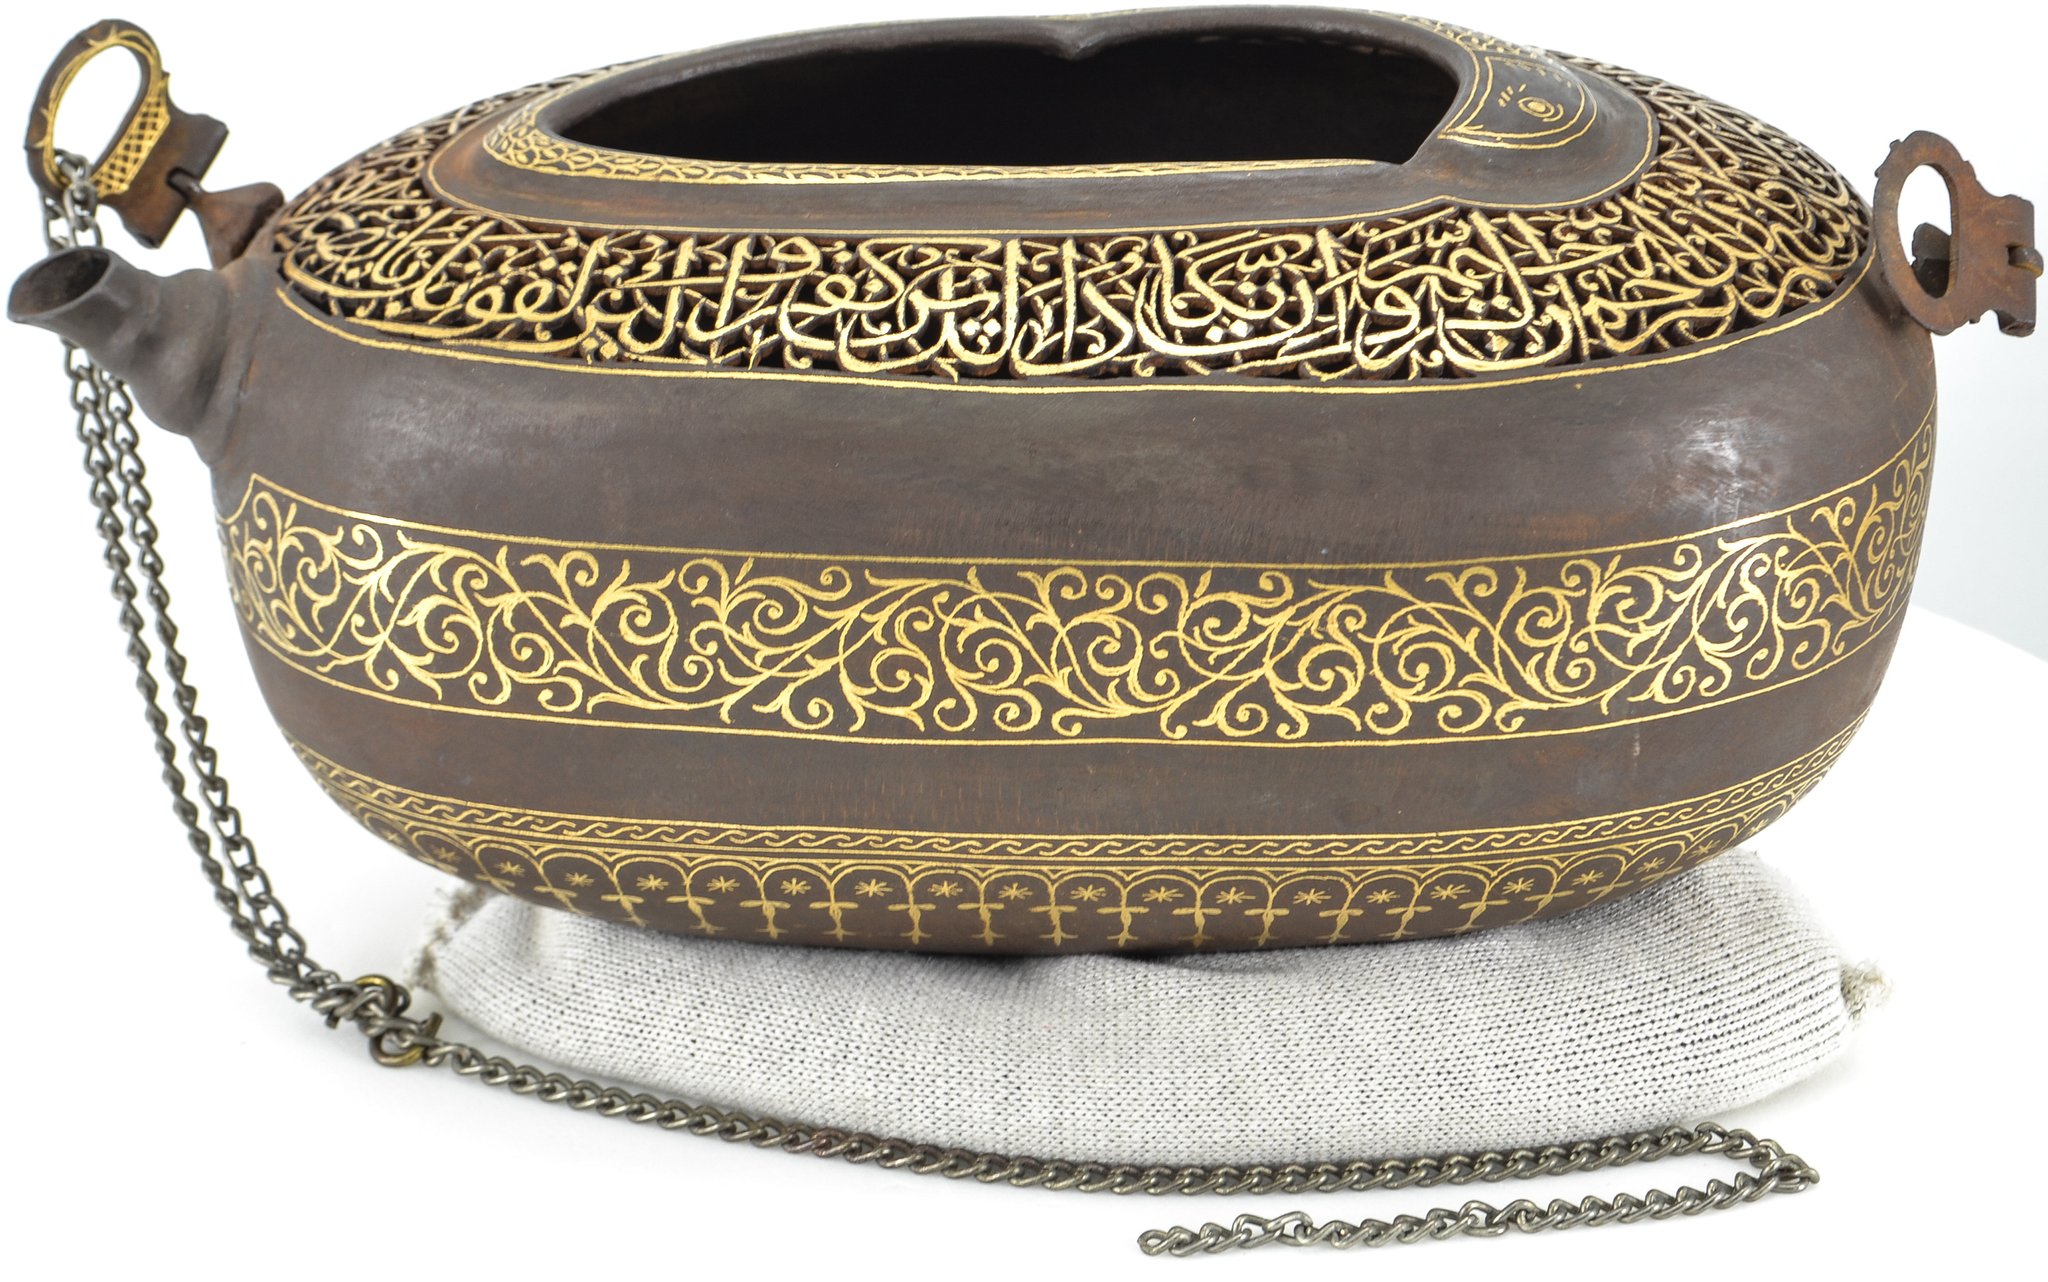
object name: beggar's bowl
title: Beggar's Bowl (Kashkul)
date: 1867-1933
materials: gold, steel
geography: iran